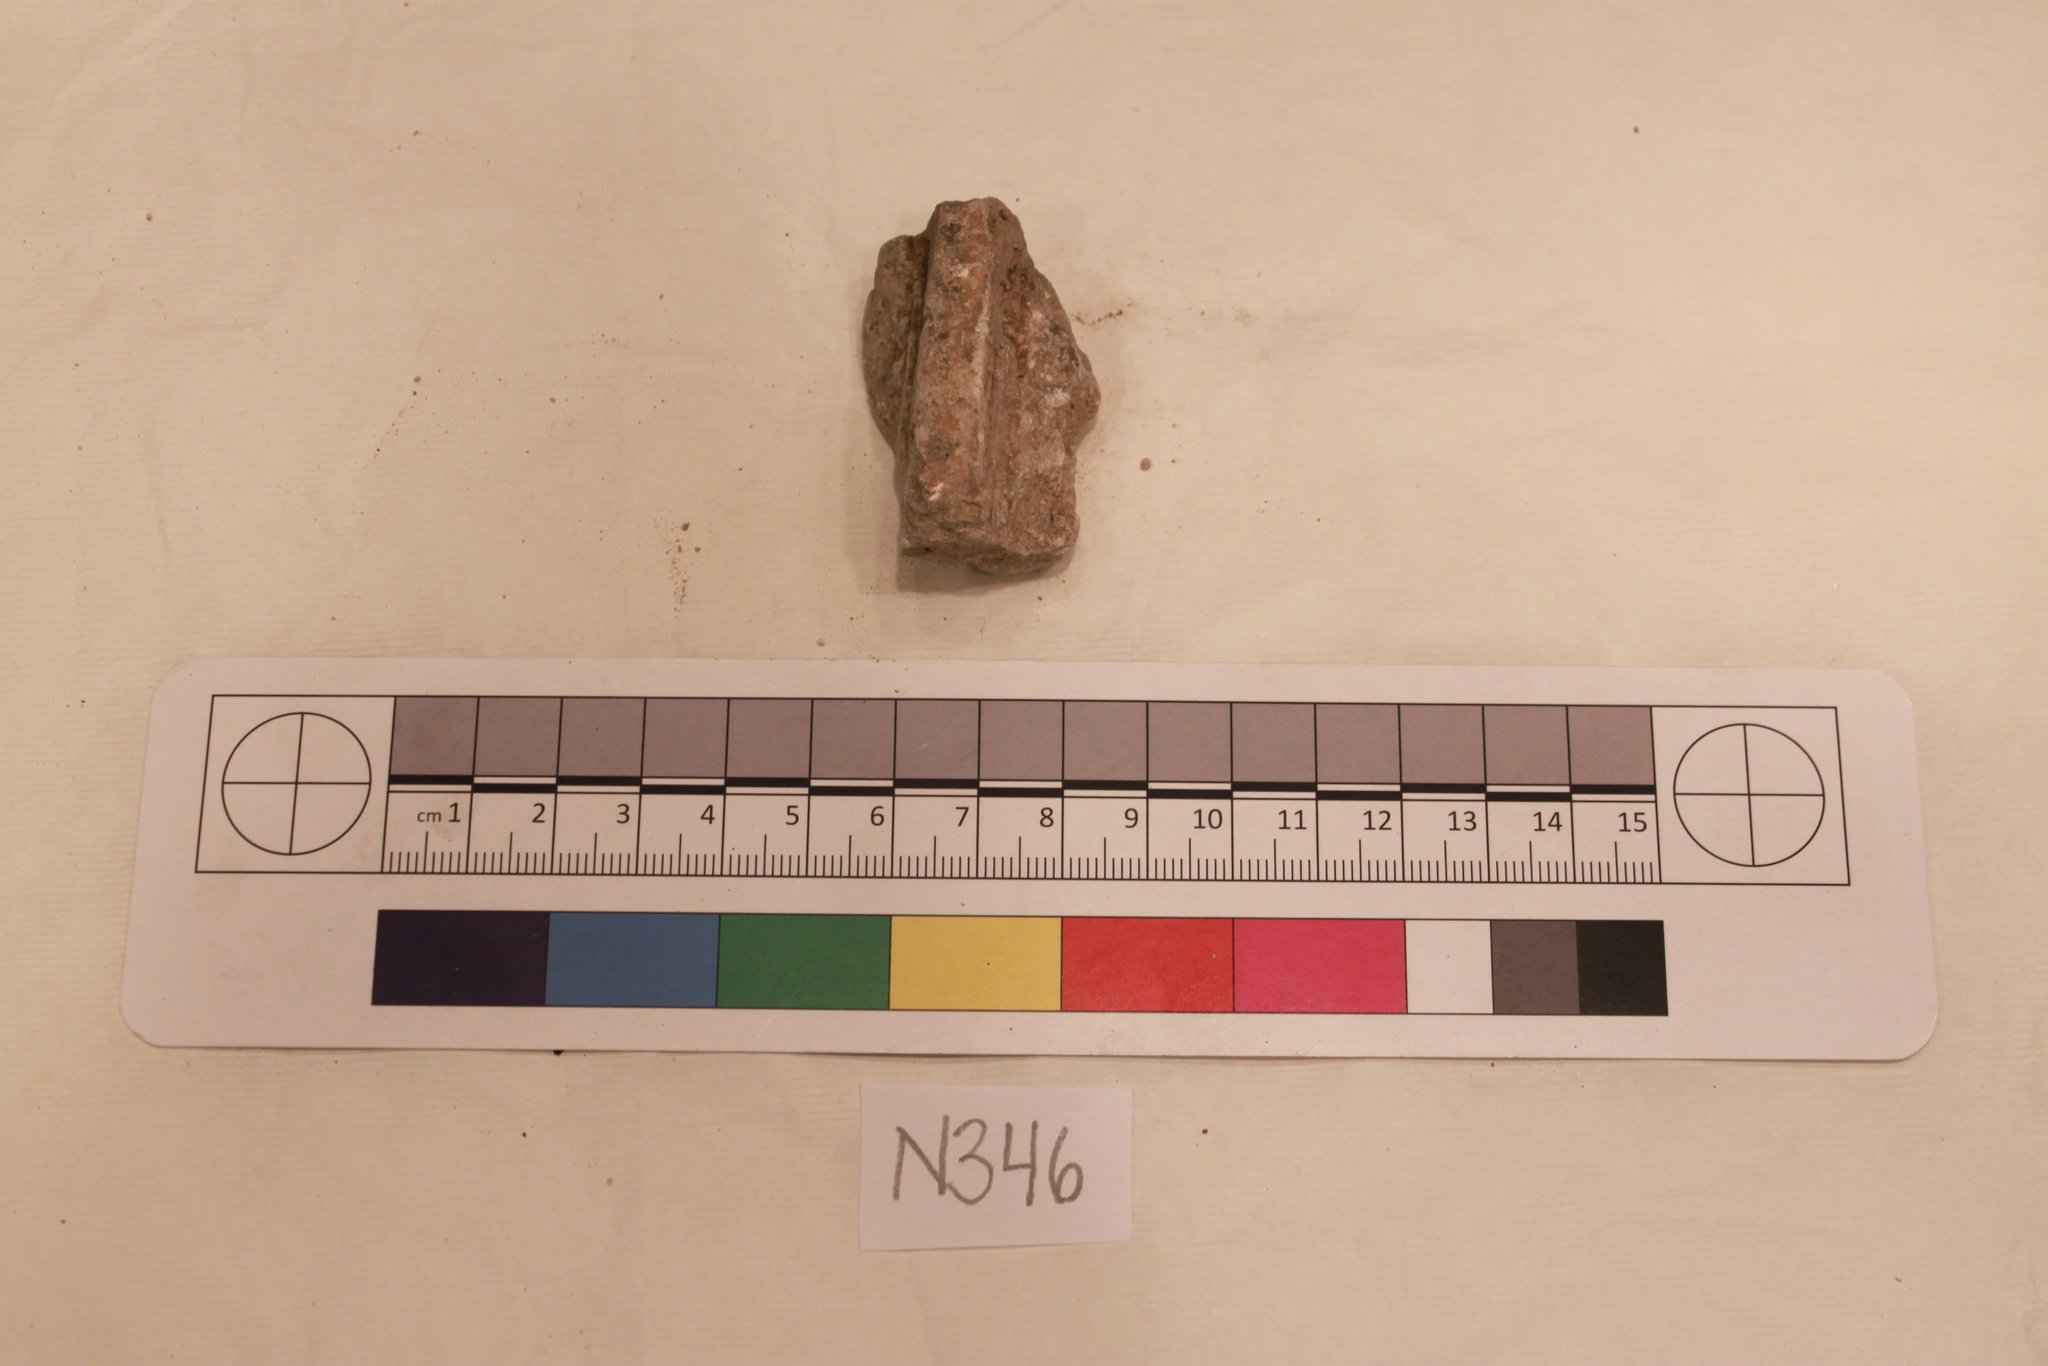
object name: fragment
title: Stucco Fragment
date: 701-1200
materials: plaster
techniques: carving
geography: iran